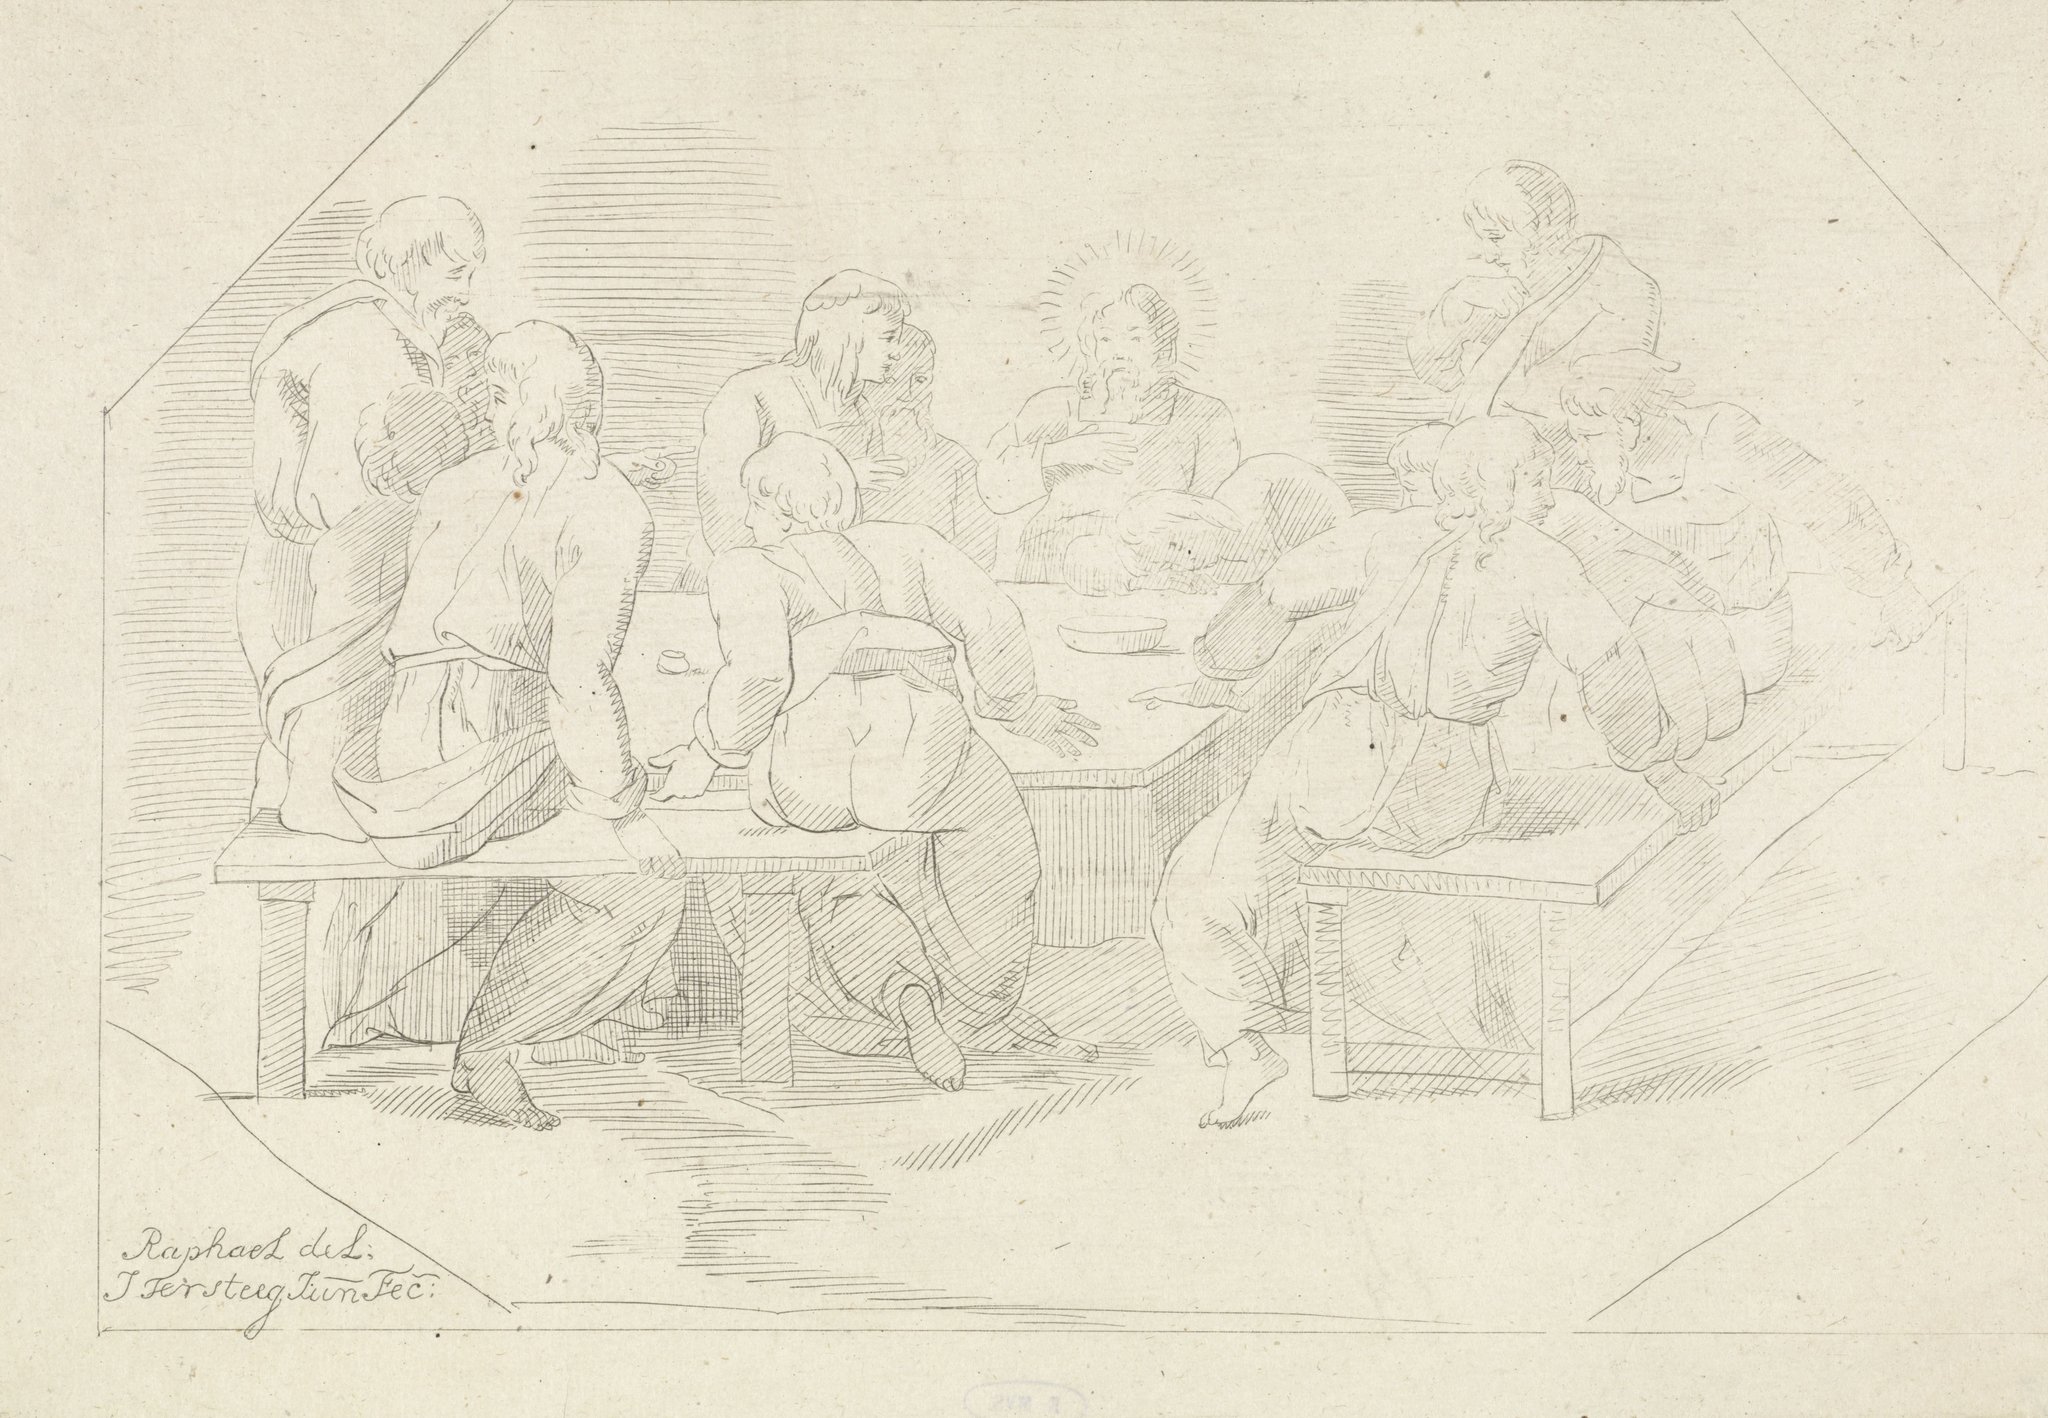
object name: print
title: Laatste avondmaal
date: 1765-1807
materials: paper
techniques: etching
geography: amsterdam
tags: announcement of the betrayal of christ, and the reaction of the apostles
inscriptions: collector's mark: Lugt 2228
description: Het laatste avondmaal van Christus met zijn leerlingen. De leerlingen schrikken van de aankondiging dat een van hen Christus zal verraden.